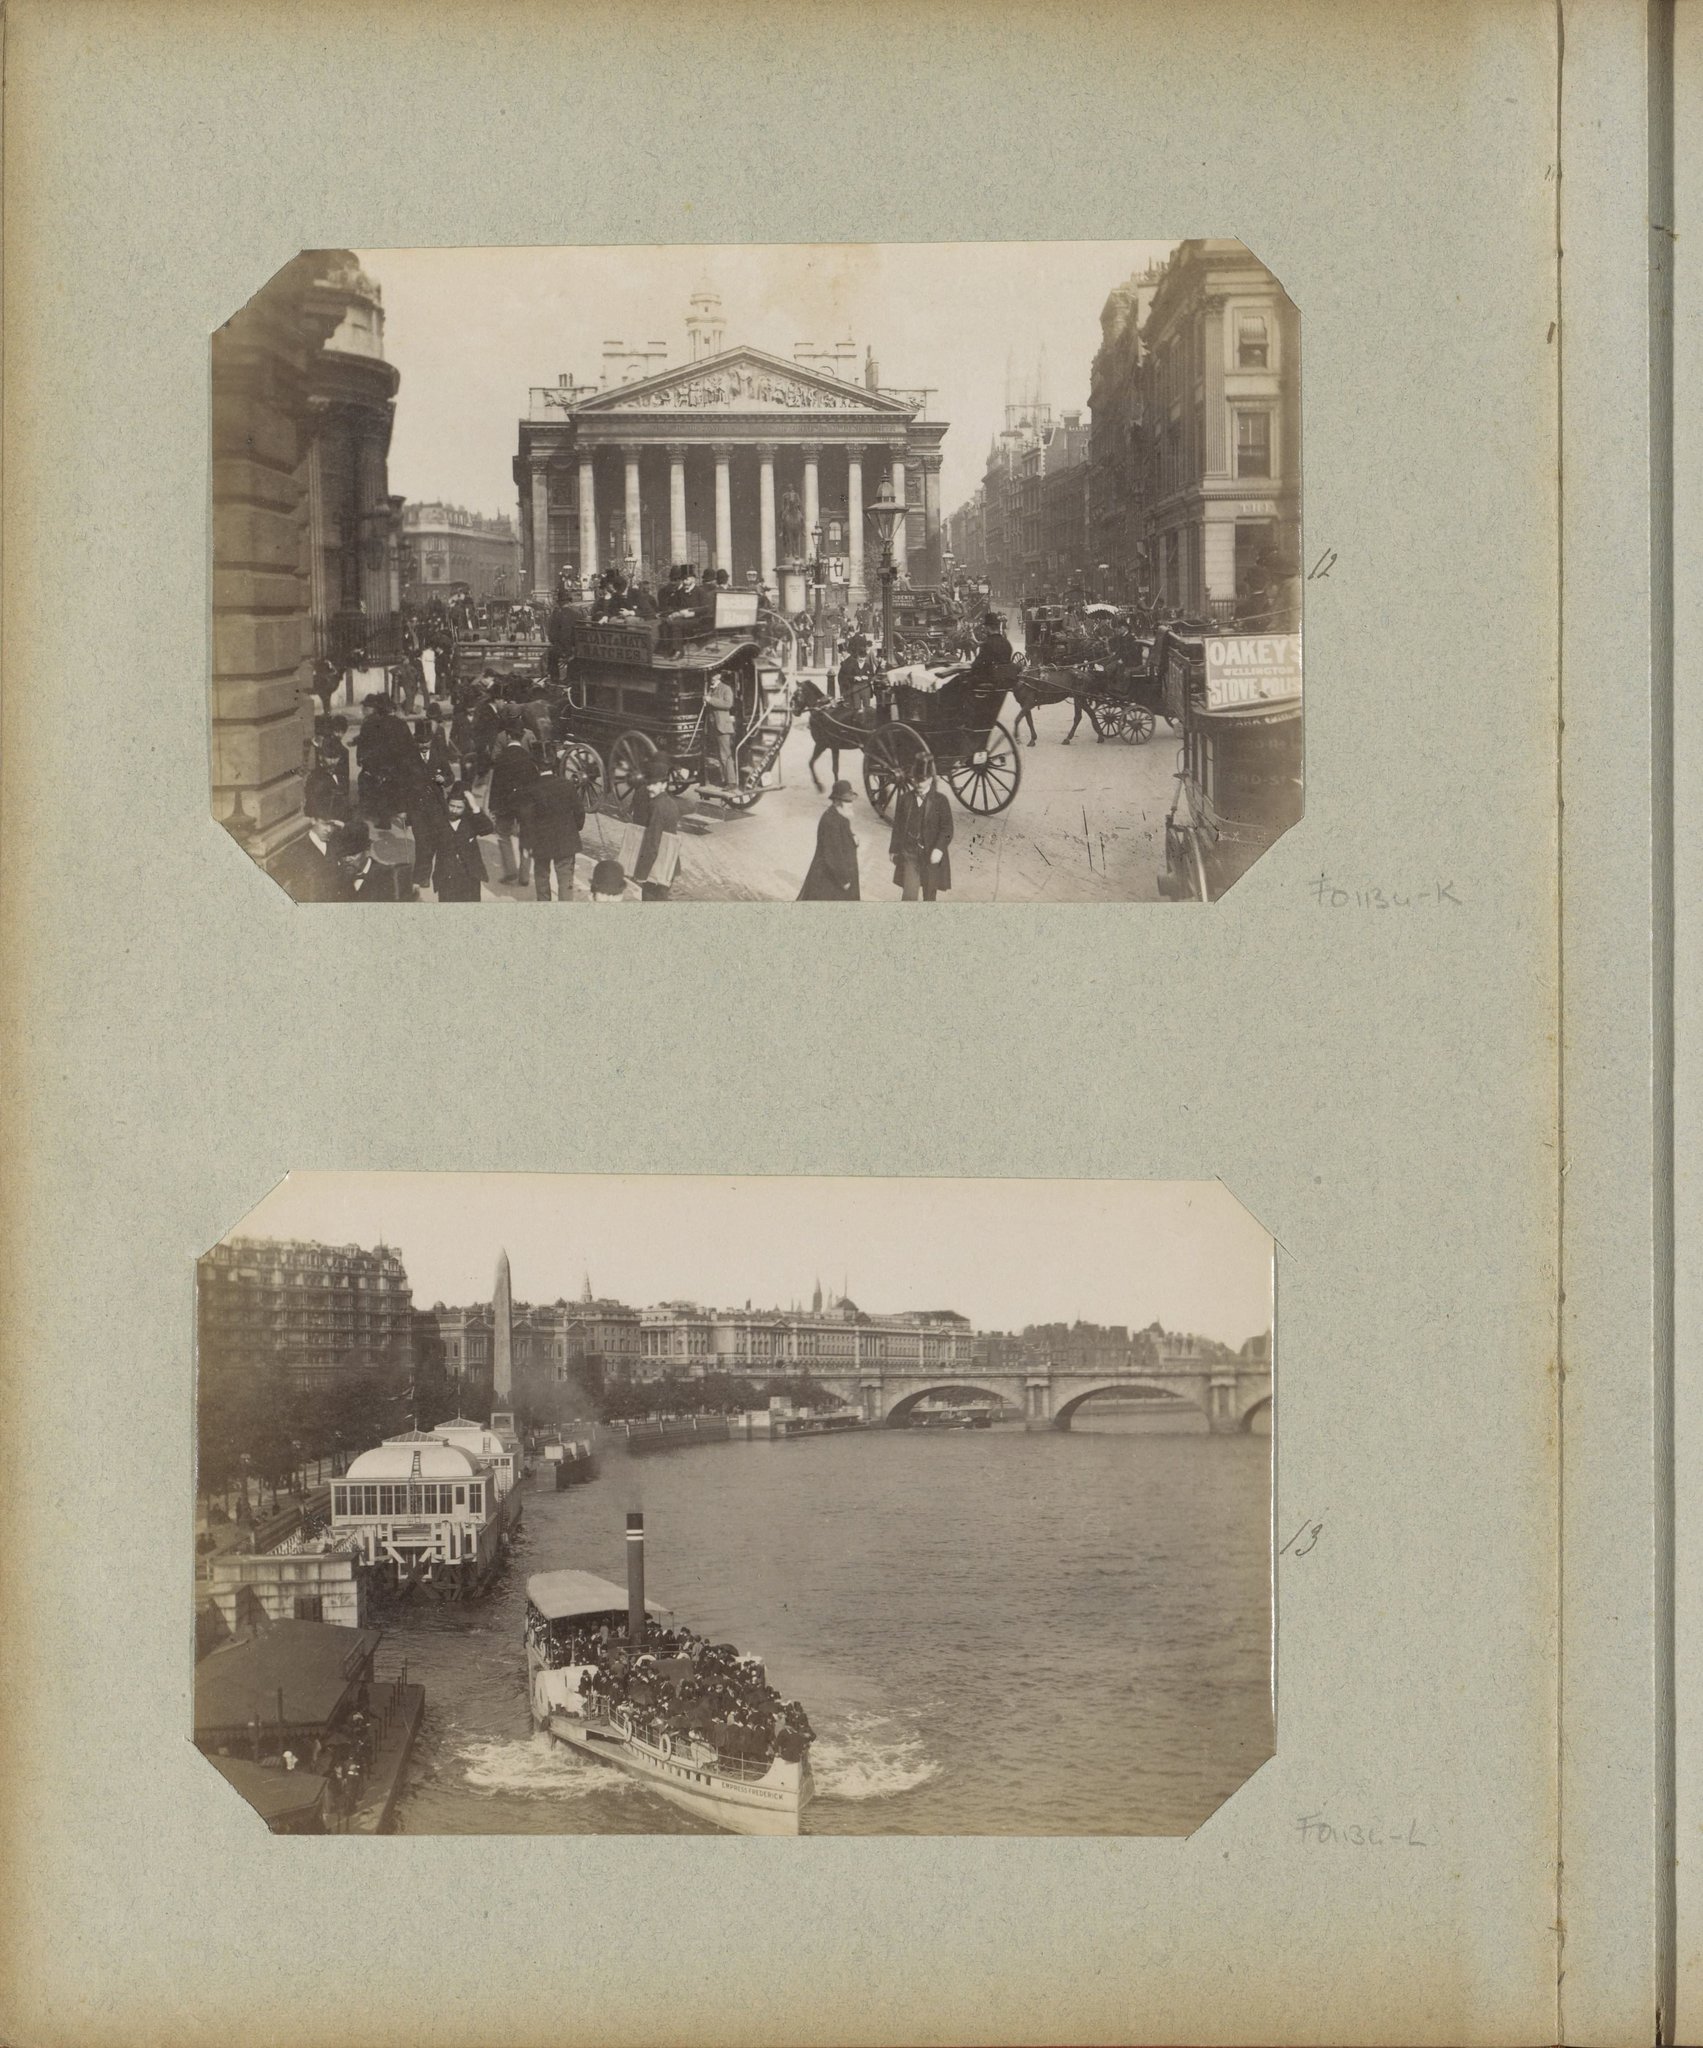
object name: album leaf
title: Straatgezicht bij de Royal Exchange in Londen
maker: Anonymous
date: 1880-1910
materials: paper, photographic support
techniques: albumen print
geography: london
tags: stock exchange, stock-market, street (+ city(-scape) with figures, staffage), london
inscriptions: number: ‘4896’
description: Onderdeel van Reisalbum met bezienswaardigheden in Engeland, Zwitserland, Frankrijk en Duitsland.